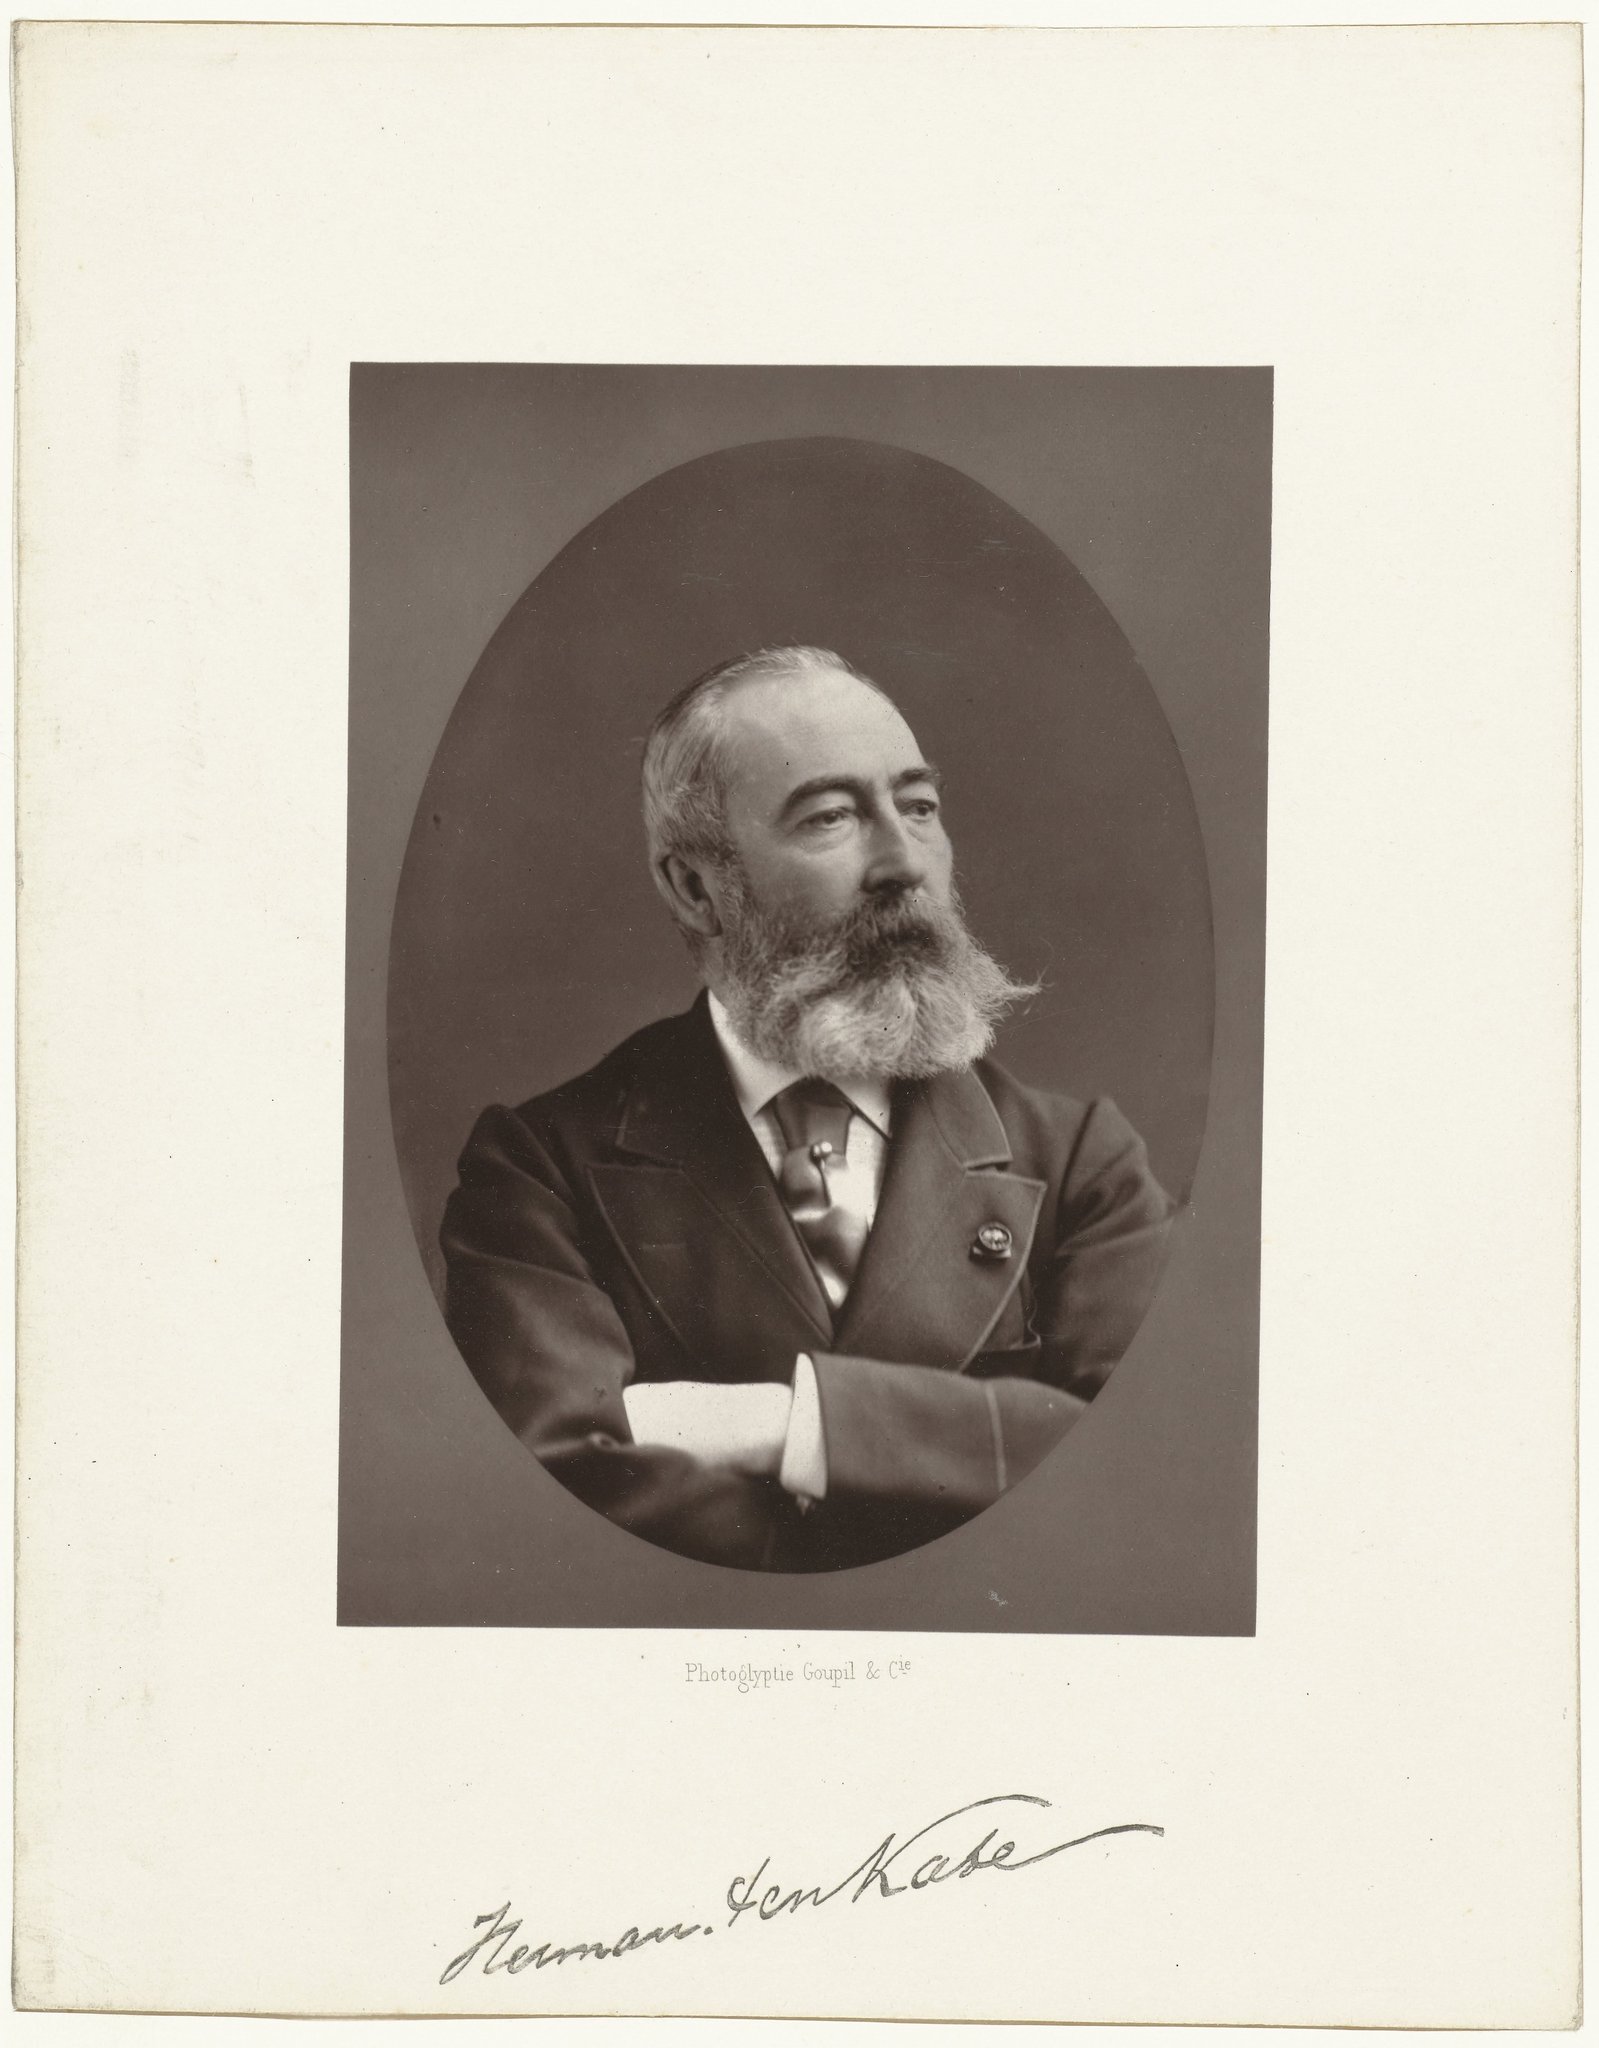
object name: photograph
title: Portret van Herman ten Kate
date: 1881-1885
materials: cardboard, paper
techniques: woodburytype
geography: the hague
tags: the hague, painter, print maker, draughtsman, herman frederik carel ten kate, historical persons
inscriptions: annotation: ‘Herman ten Kate’